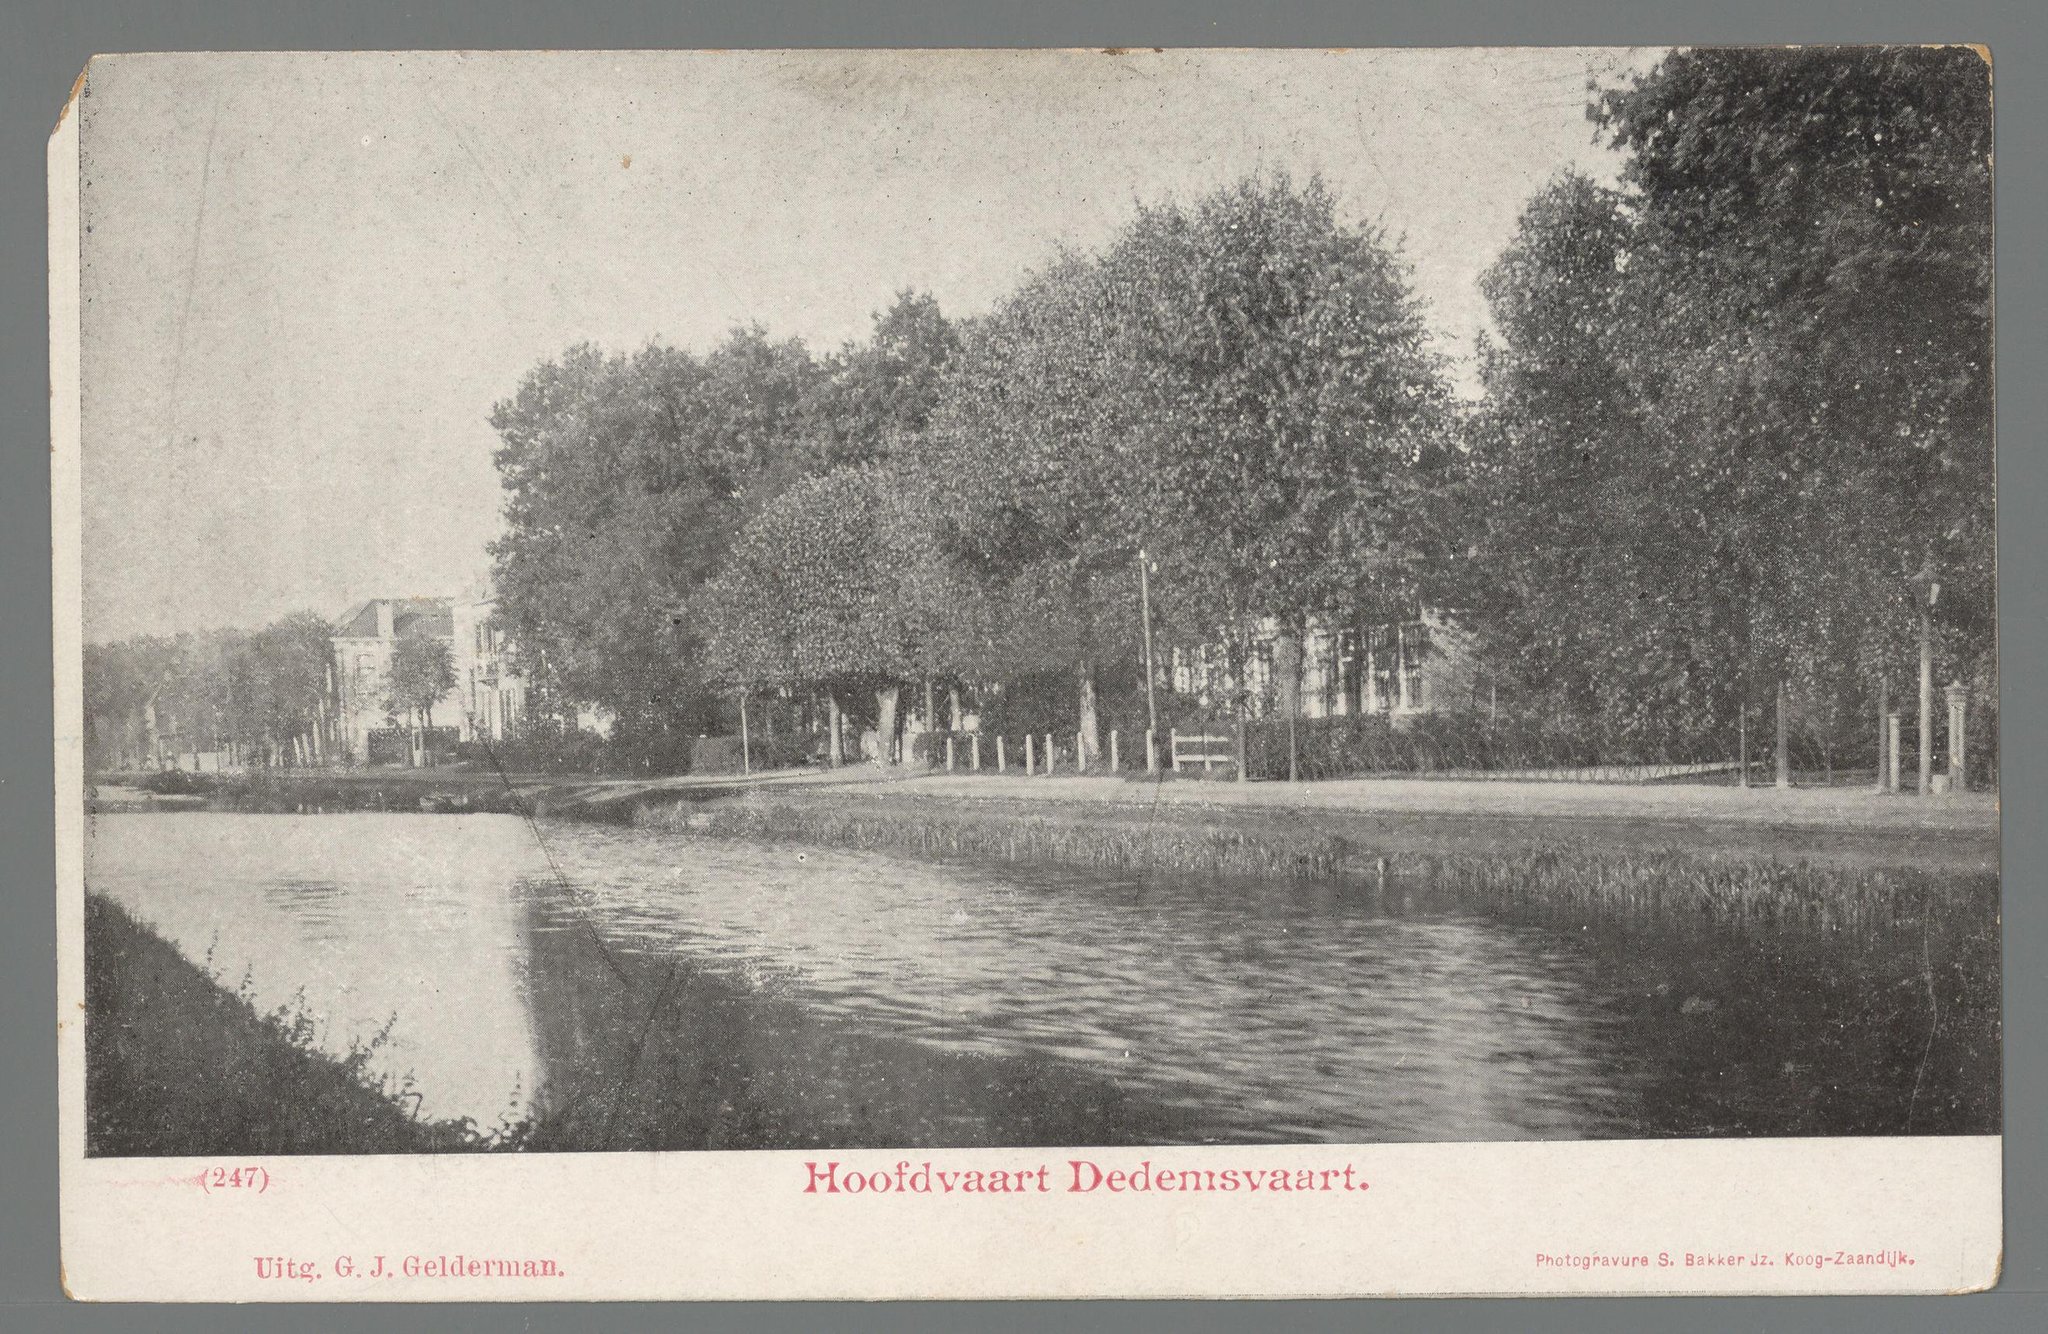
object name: ansichtkaart, prentbriefkaart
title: Hoofdvaart Dedemsvaart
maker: simon bakker jz.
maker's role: printer, publisher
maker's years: 1873-1930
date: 1897-1905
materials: cardboard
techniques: autotype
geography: dedemsvaart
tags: canals, waters (in village)